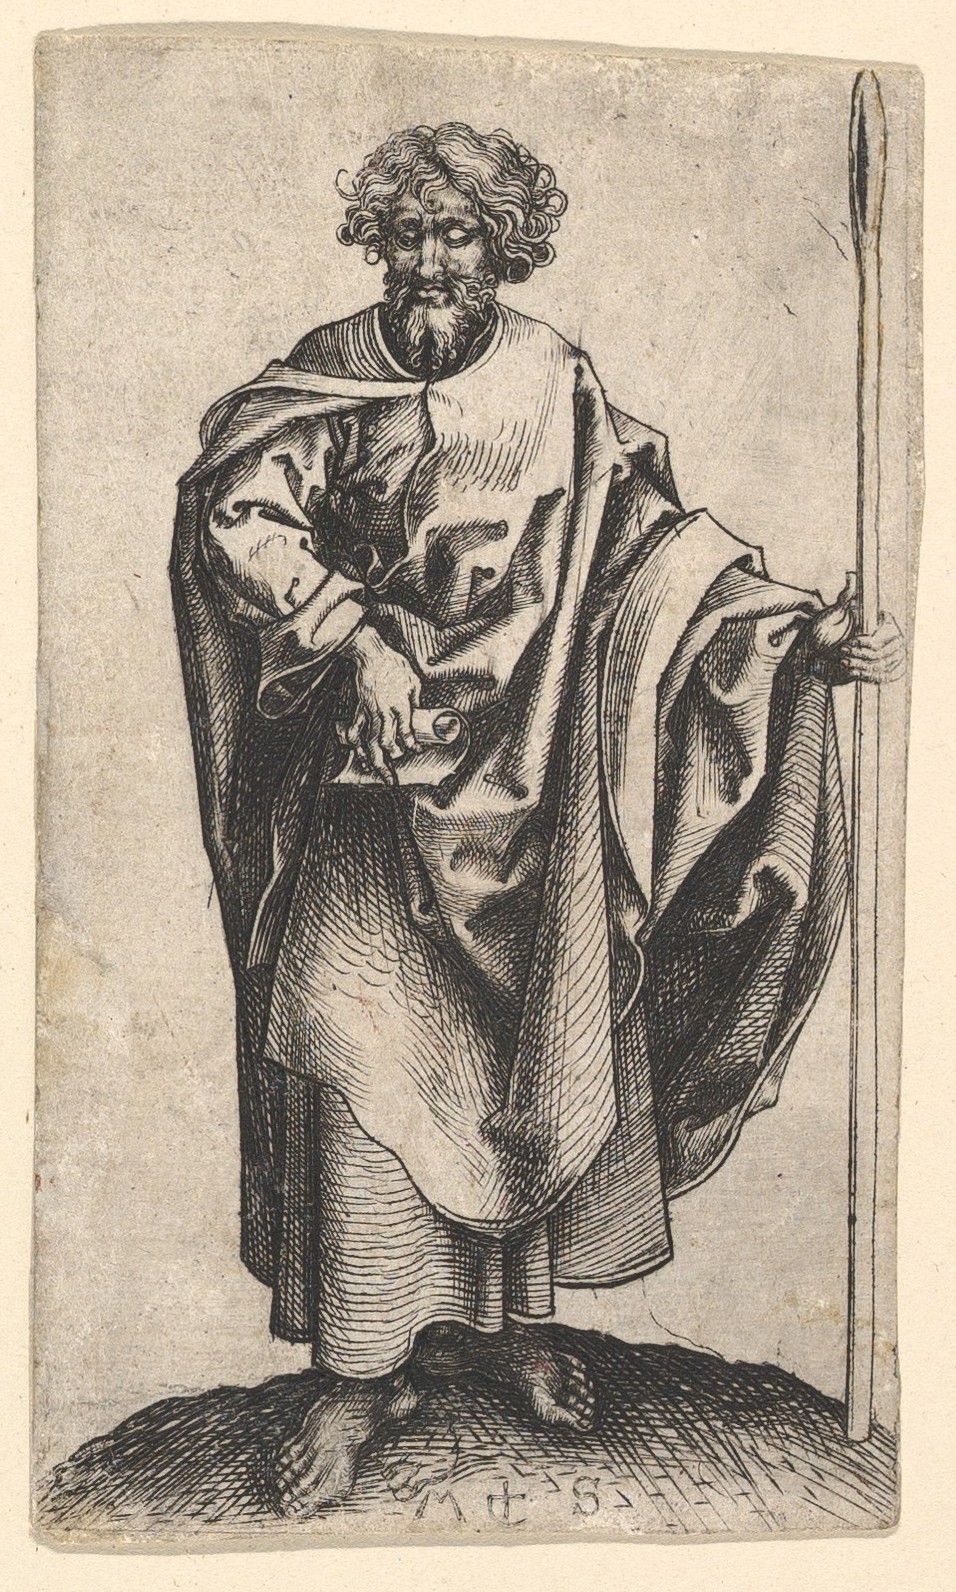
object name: print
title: St. Thomas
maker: martin schongauer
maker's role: artist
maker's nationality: german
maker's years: 1430-1491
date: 1470-1491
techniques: engraving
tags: men,saints